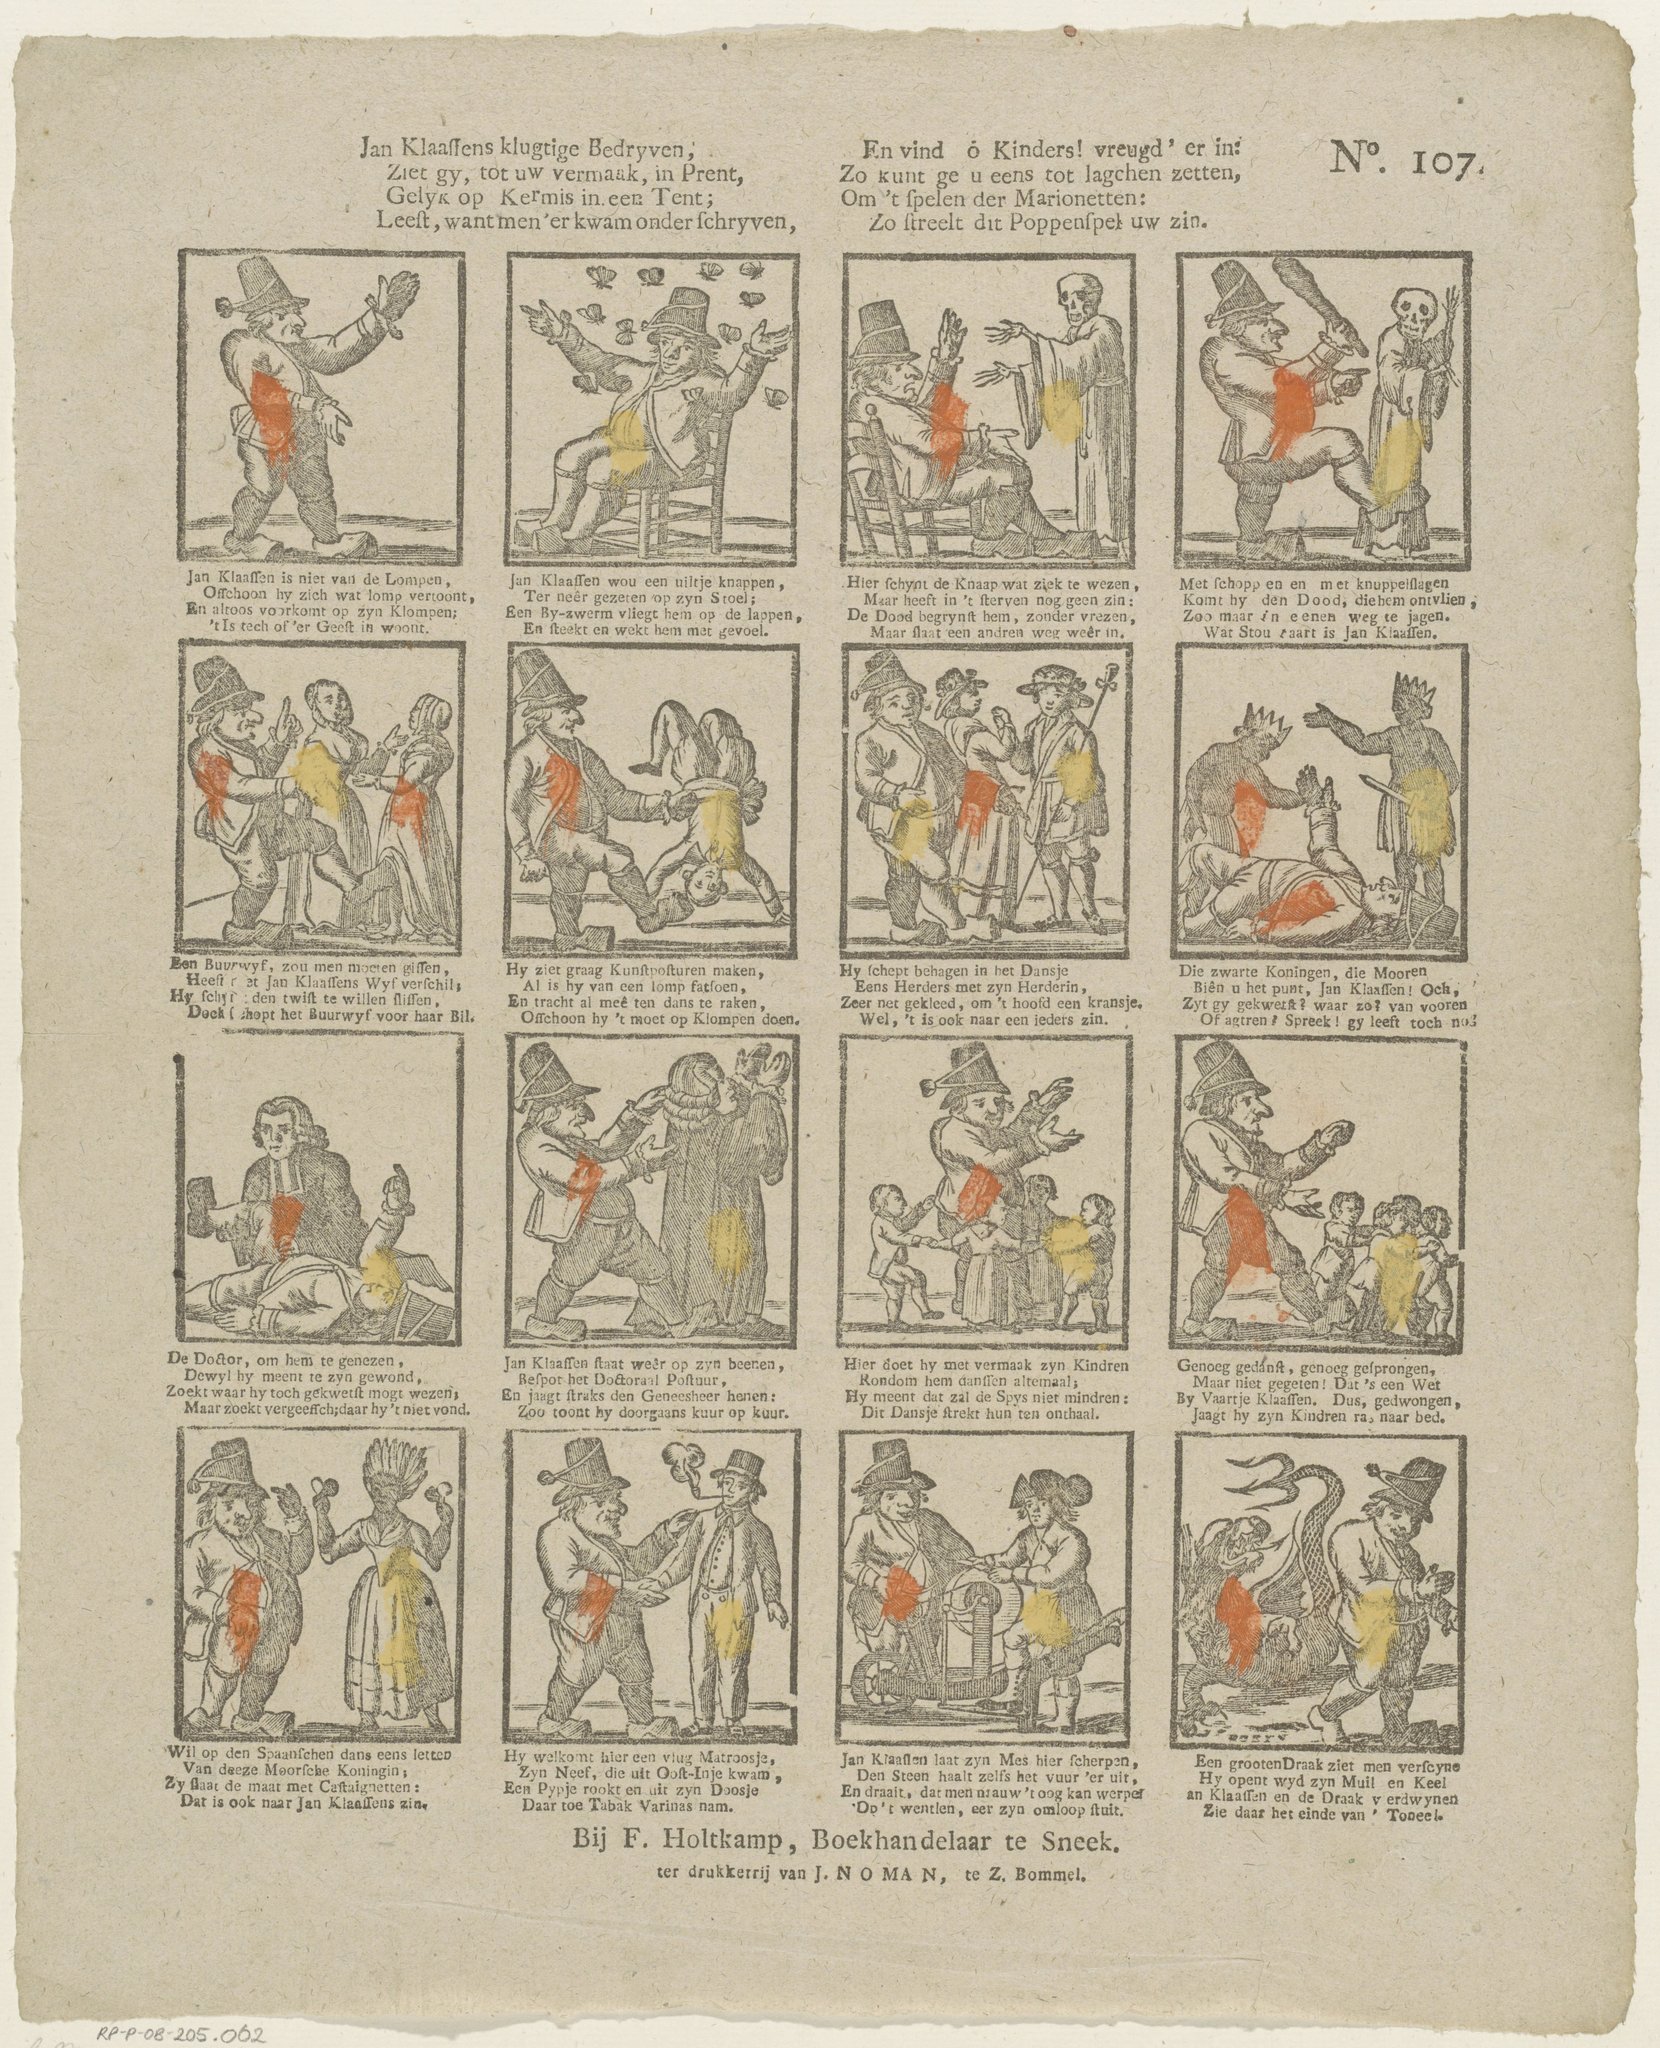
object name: popular print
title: Jan klaassens klugtige bedryven, / Ziet gy, tot uw vermaak, in prent [(...)]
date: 1806-1830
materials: paper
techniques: colour, letterpress printing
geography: sneek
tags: punch and judy, tales and fairy tales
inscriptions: collector's mark: Lugt 2760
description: Blad met 16 voorstellingen over het leven van Jan Klaassen. Onder elke afbeelding een vierregelig vers. Genummerd rechtsboven: No. 107.